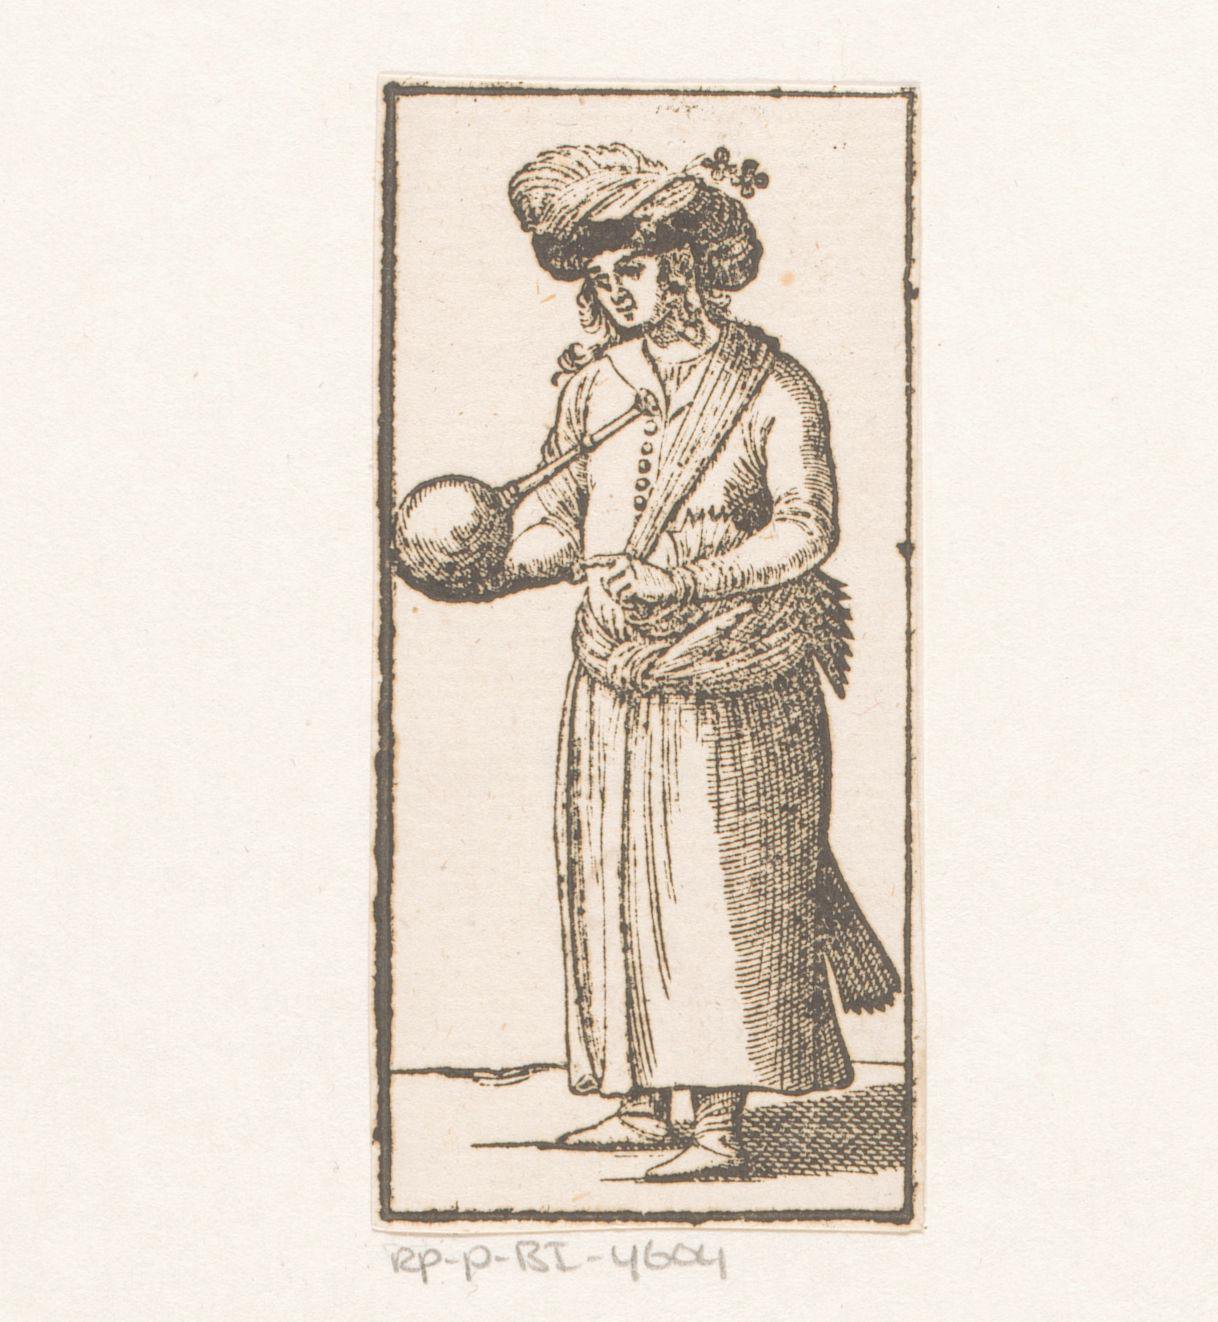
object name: print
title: Staande man met een tulband en een instrument in zijn hand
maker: Anonymous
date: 1600-1699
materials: paper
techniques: woodcut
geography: netherlands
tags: head-gear: turban, adult man (+ standing)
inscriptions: collector's mark: Lugt 240